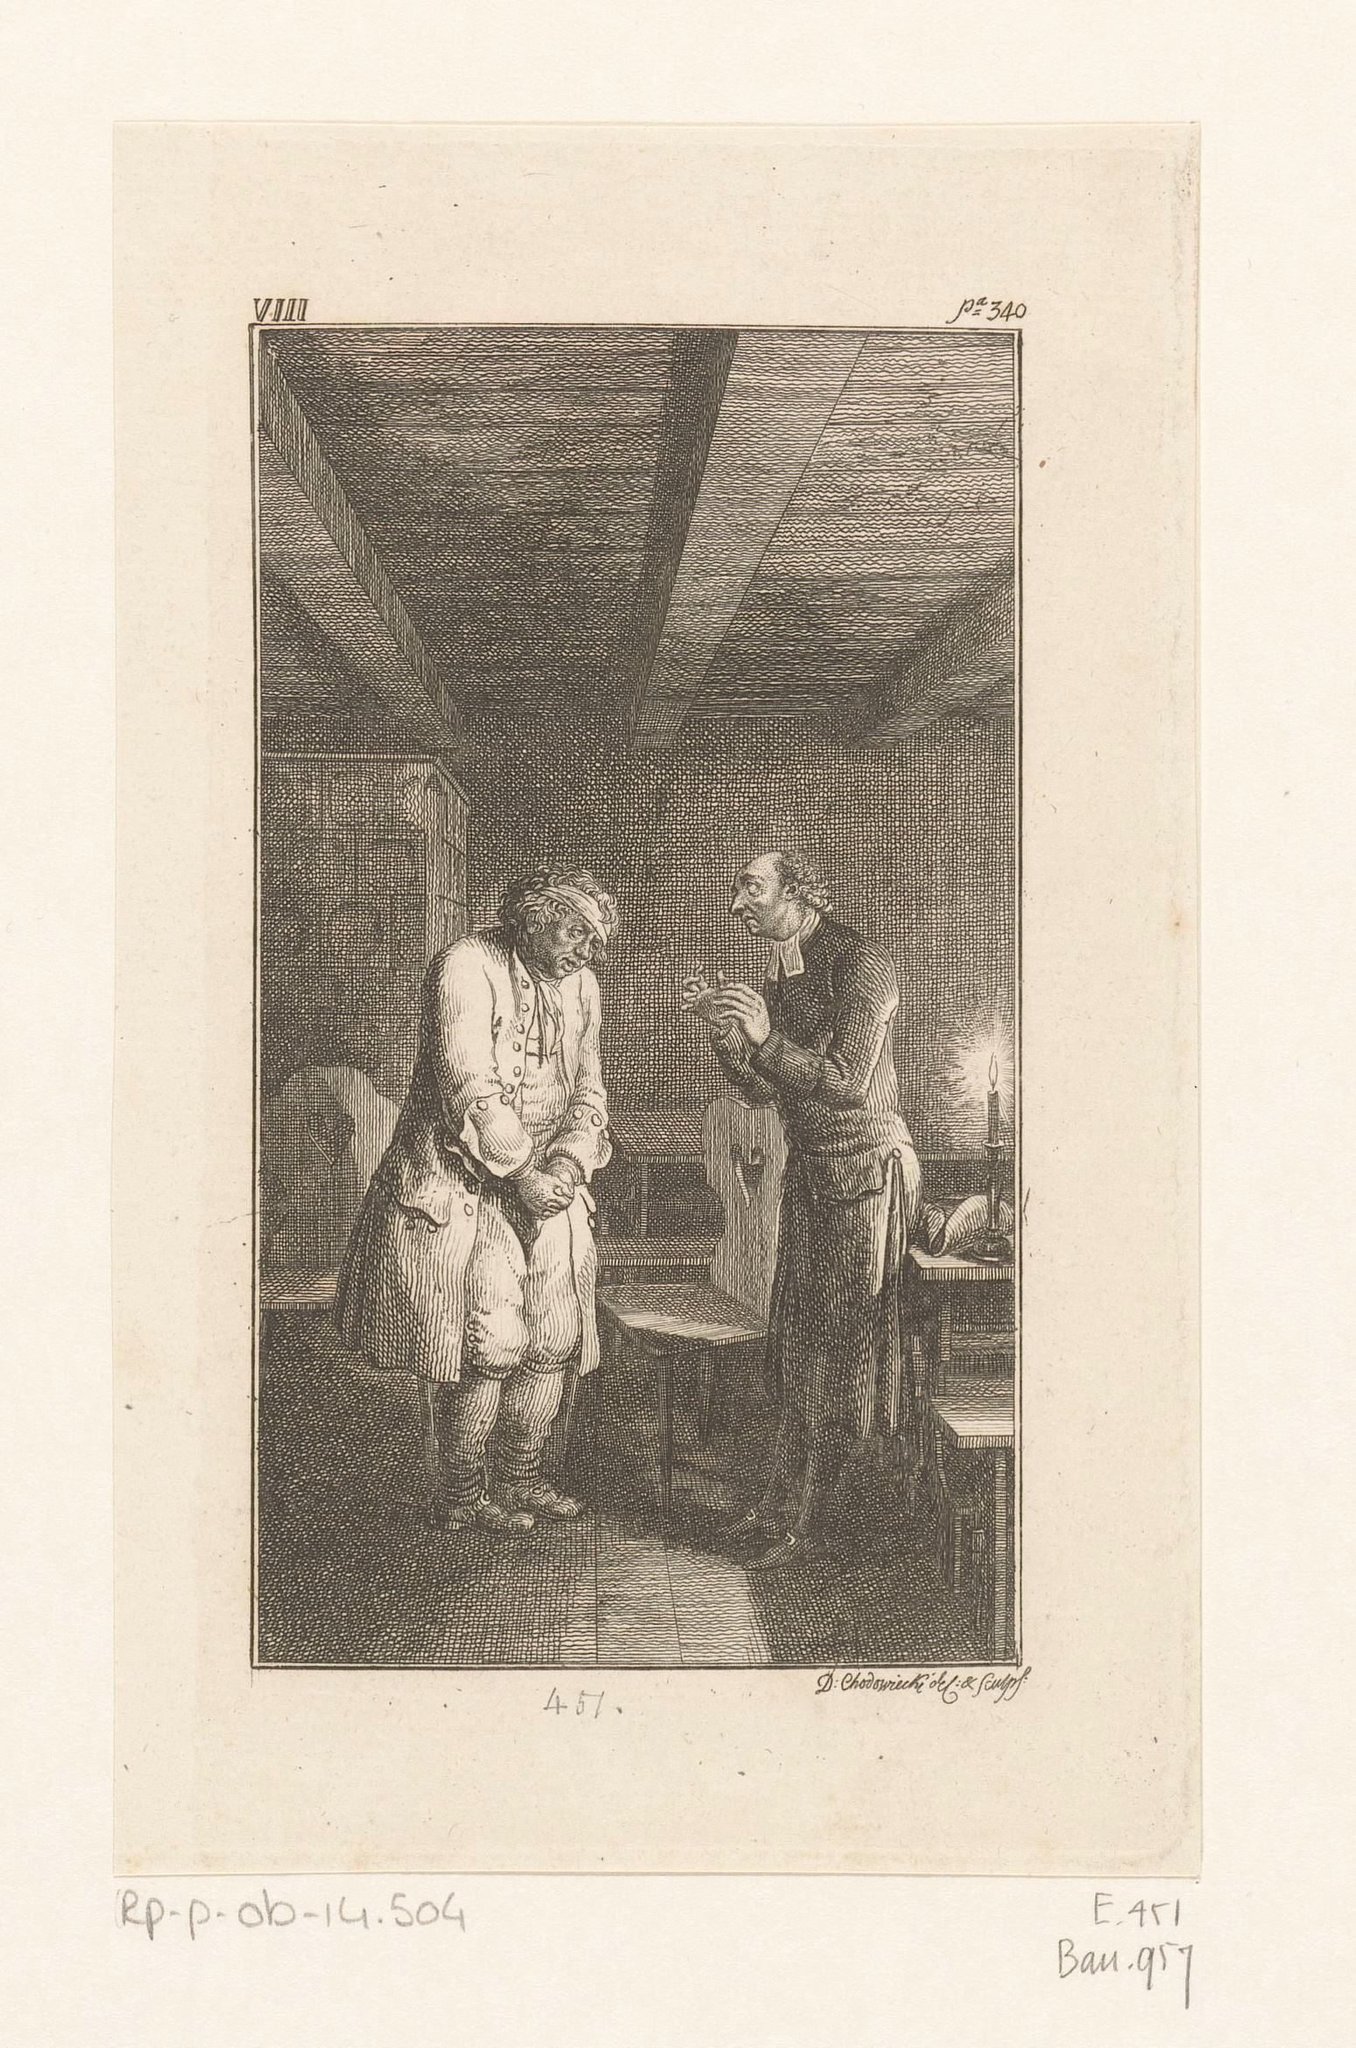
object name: book illustration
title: Hummel belooft zijn schuld te openbaren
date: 1782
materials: paper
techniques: etching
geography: berlin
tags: politician, fear, dread; 'paura', 'timidità o timore', 'timore' (ripa), interior of the house, conversation, dialogue; conversation piece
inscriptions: collector's mark: Lugt 2228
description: Prent gebruikt voor: Pestalozzi, Johann Heinrich. Léonard et Gertrude ou Les moeurs villageoises, telles qu'on les retrouve à la ville & à la cour. Berlijn: George Jacques Decker, 1783.